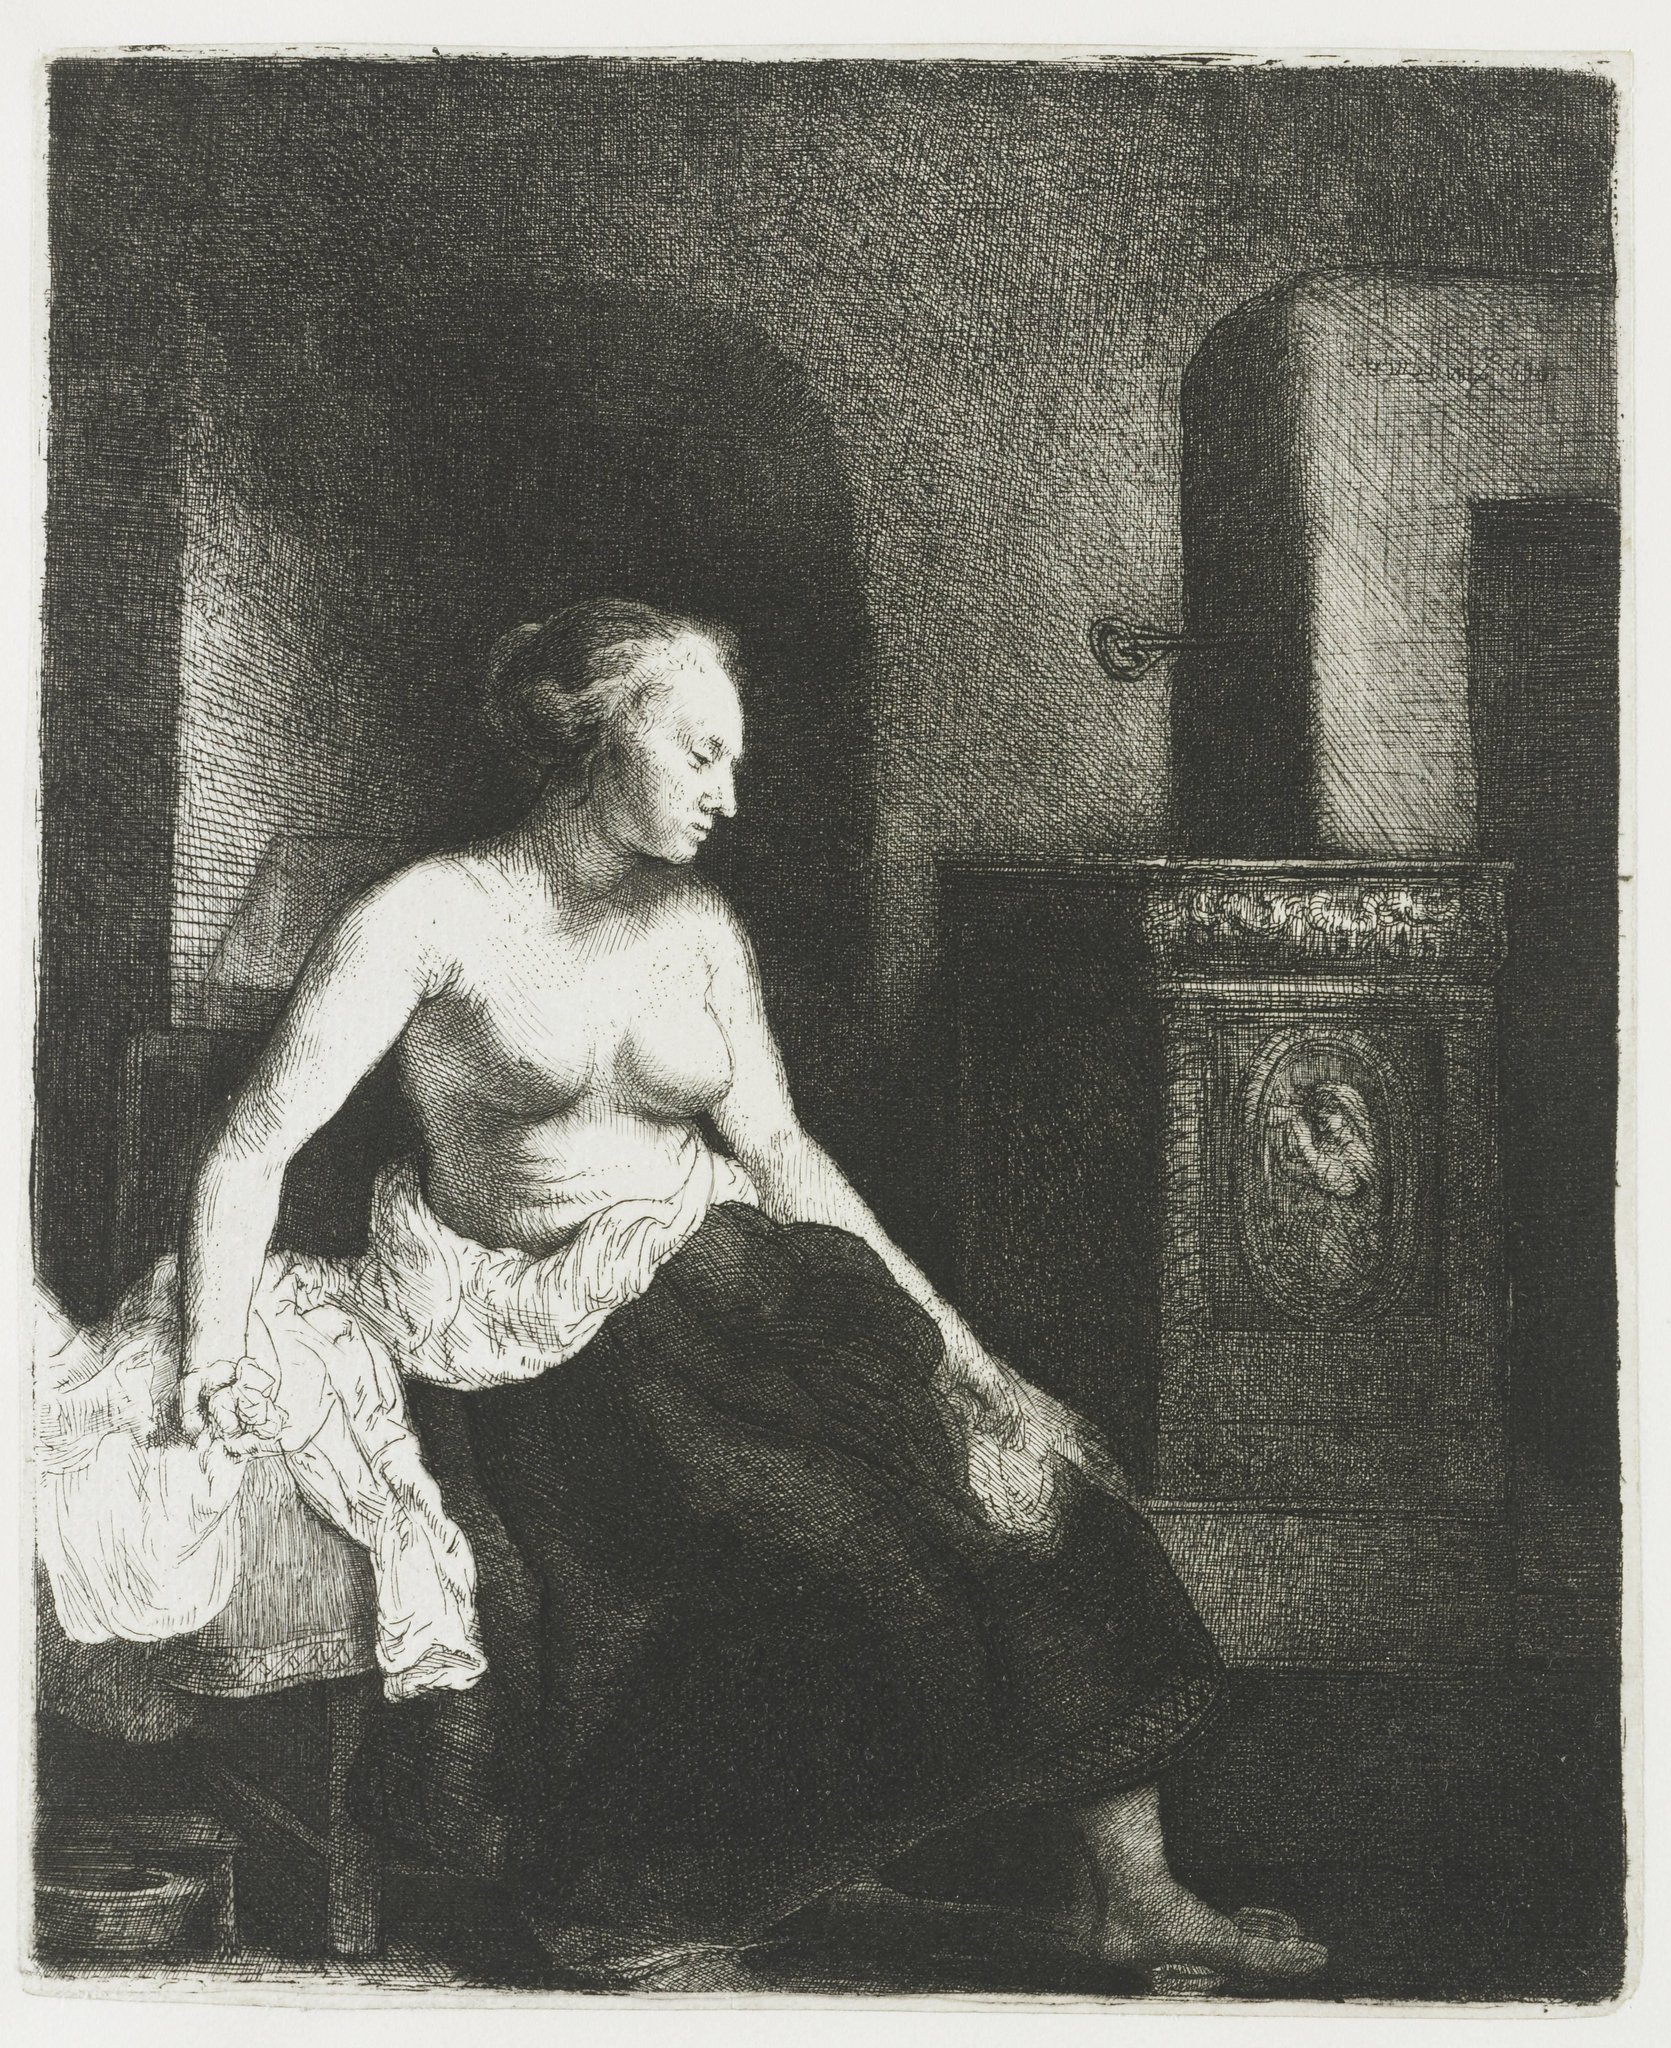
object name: print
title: Woman sitting half dressed beside a stove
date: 1658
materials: paper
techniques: drypoint, etching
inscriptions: signature and date: ‘Rembrandt f. 1658’, collector's mark: Lugt 1119 b, collector's mark: Lugt 2228